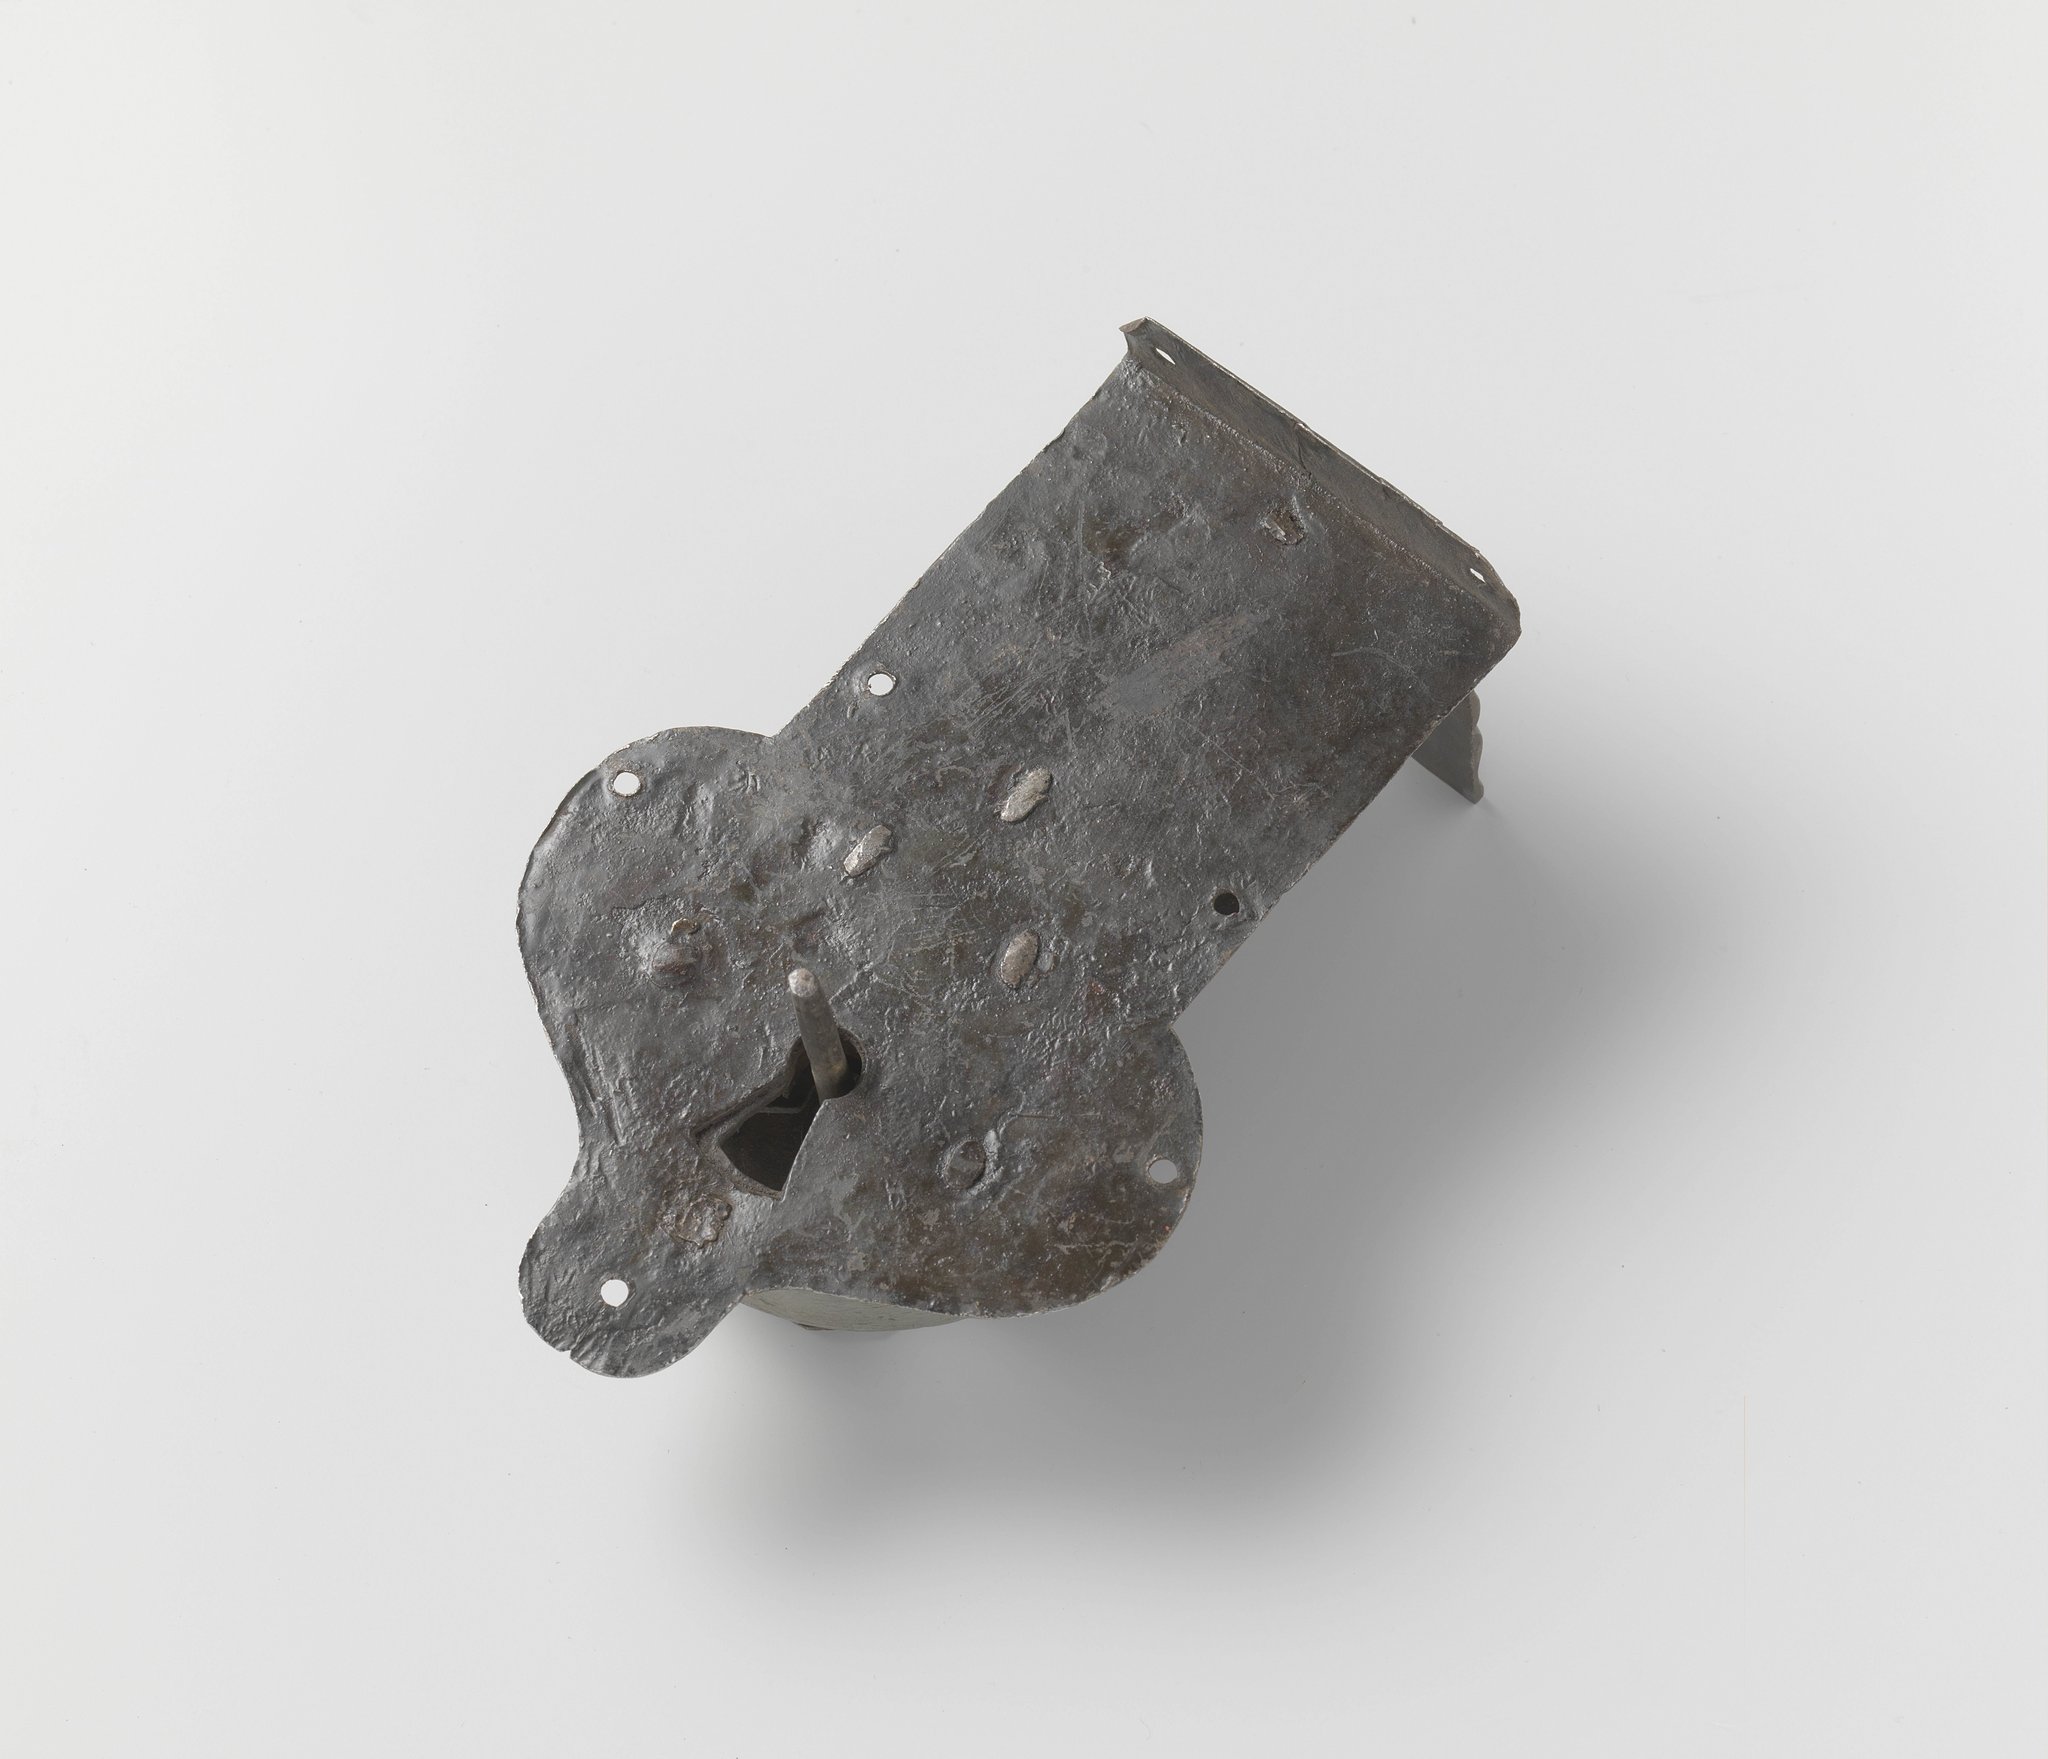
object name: lock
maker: Anonymous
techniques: engraving